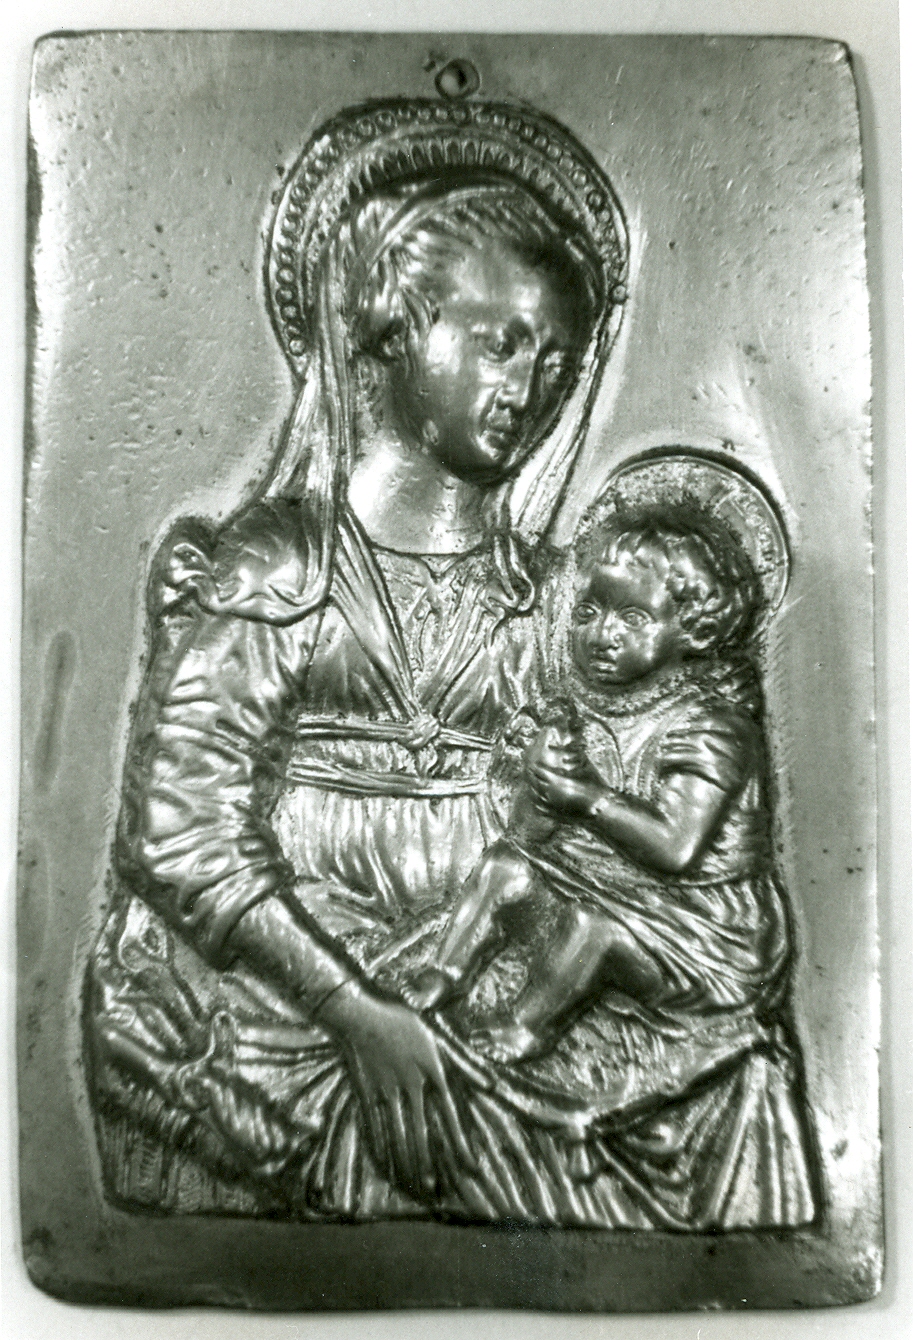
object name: plaquette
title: Virgin and Child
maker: antonio rossellino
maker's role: artist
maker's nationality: italian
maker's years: 1427-1479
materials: copper alloy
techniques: gilding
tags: madonna and child